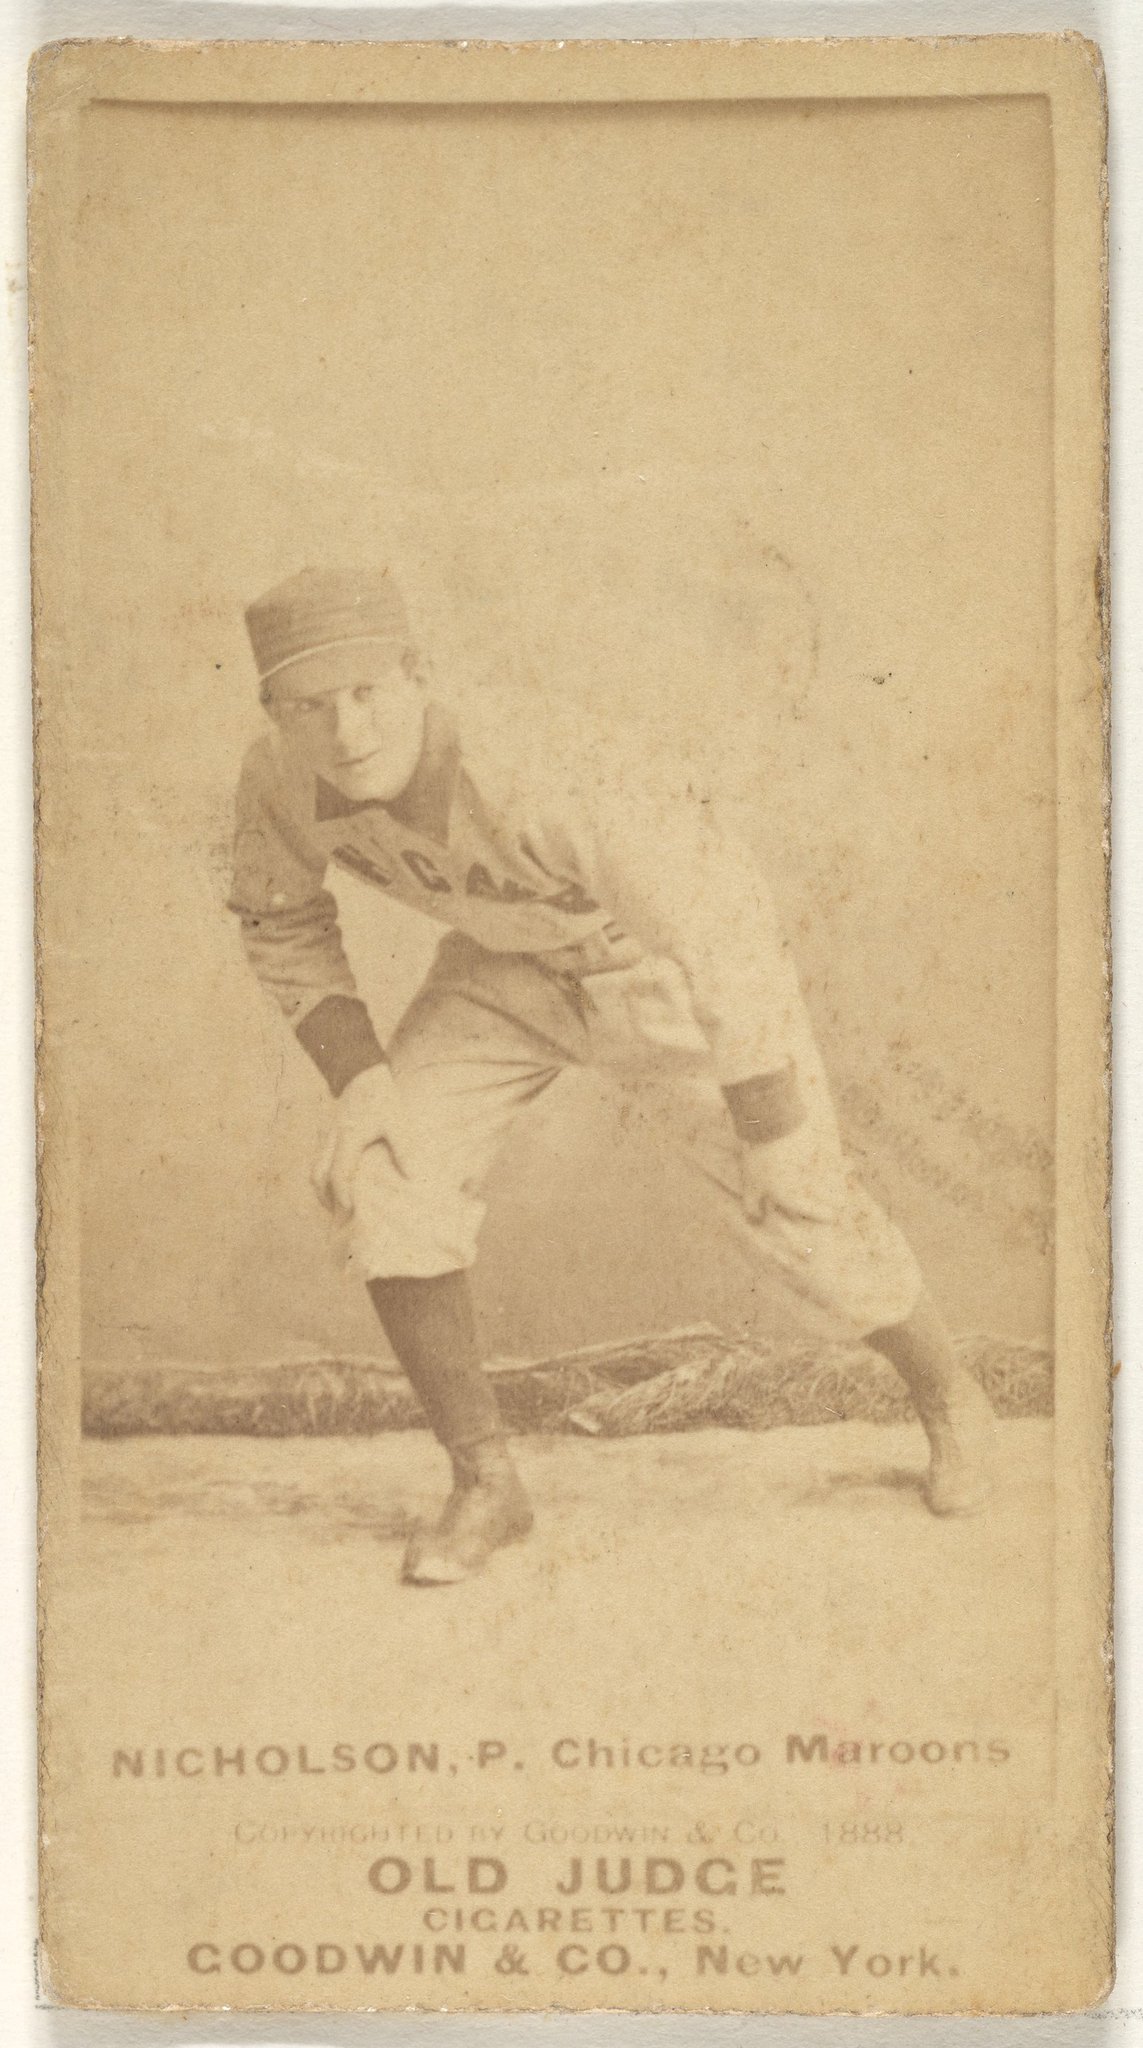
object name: baseball card, photograph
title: Nicholson, Pitcher, Chicago, from the Old Judge series (N172) for Old Judge Cigarettes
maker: goodwin & company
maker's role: publisher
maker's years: 1850-1950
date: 1888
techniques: albumen silver print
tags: men,portraits,baseball,athletes